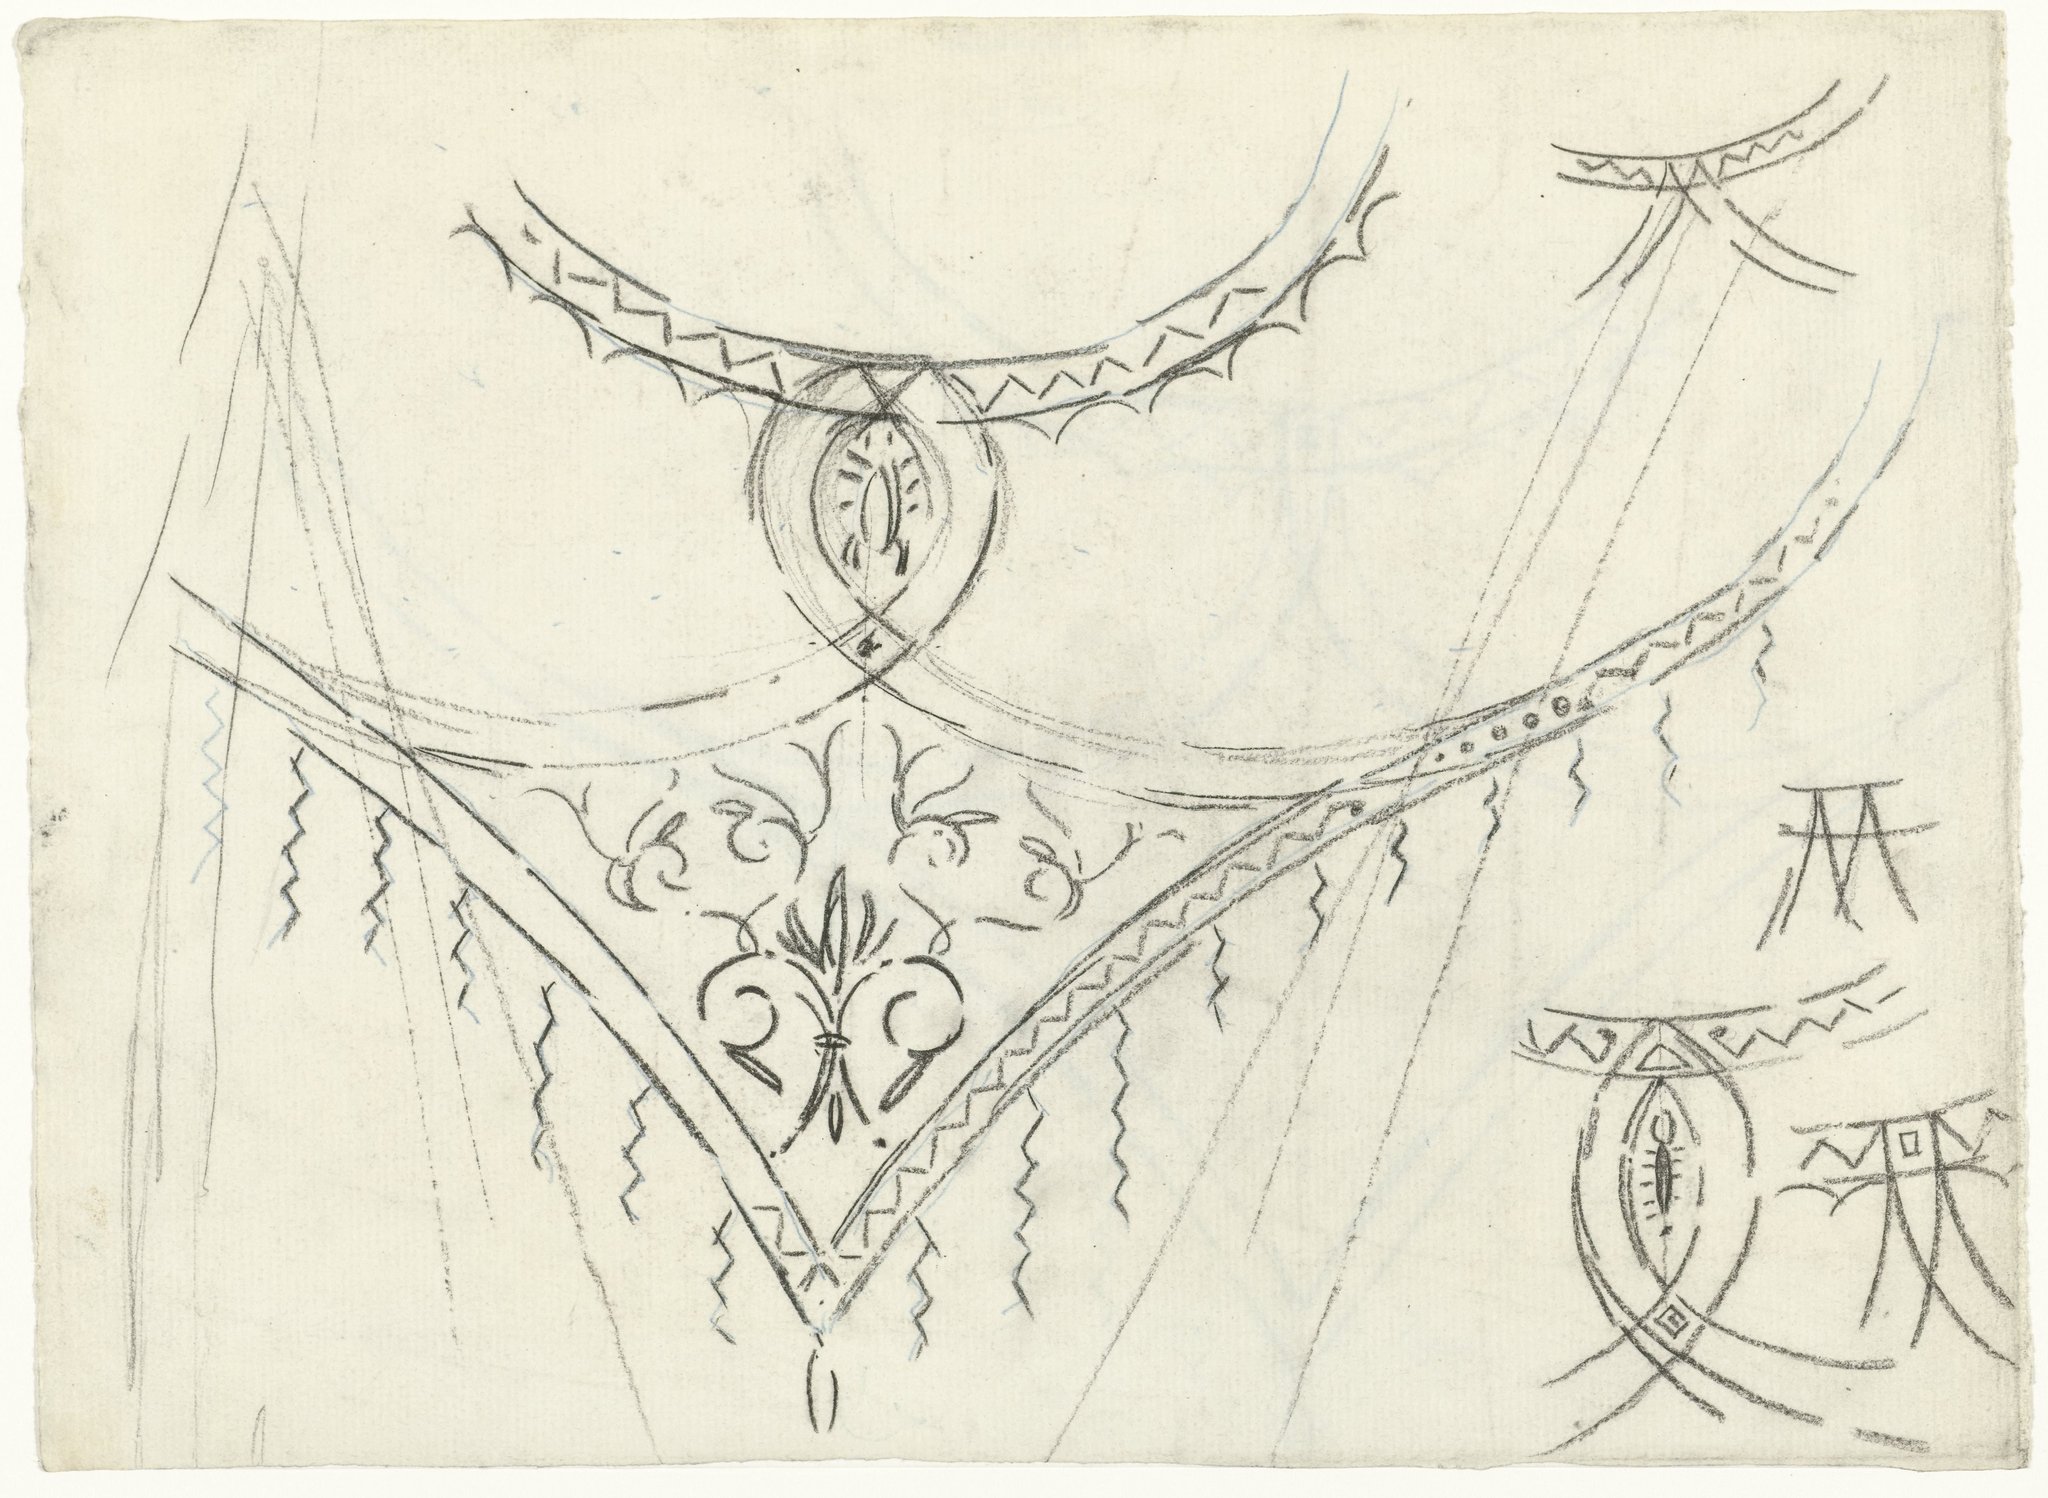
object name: drawing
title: Ontwerpen voor ornamenten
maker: gerrit willem dijsselhof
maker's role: designer, draughtsman, print maker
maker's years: 1866-1924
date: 1876-1924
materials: chalk, paper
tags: ornaments ~ art